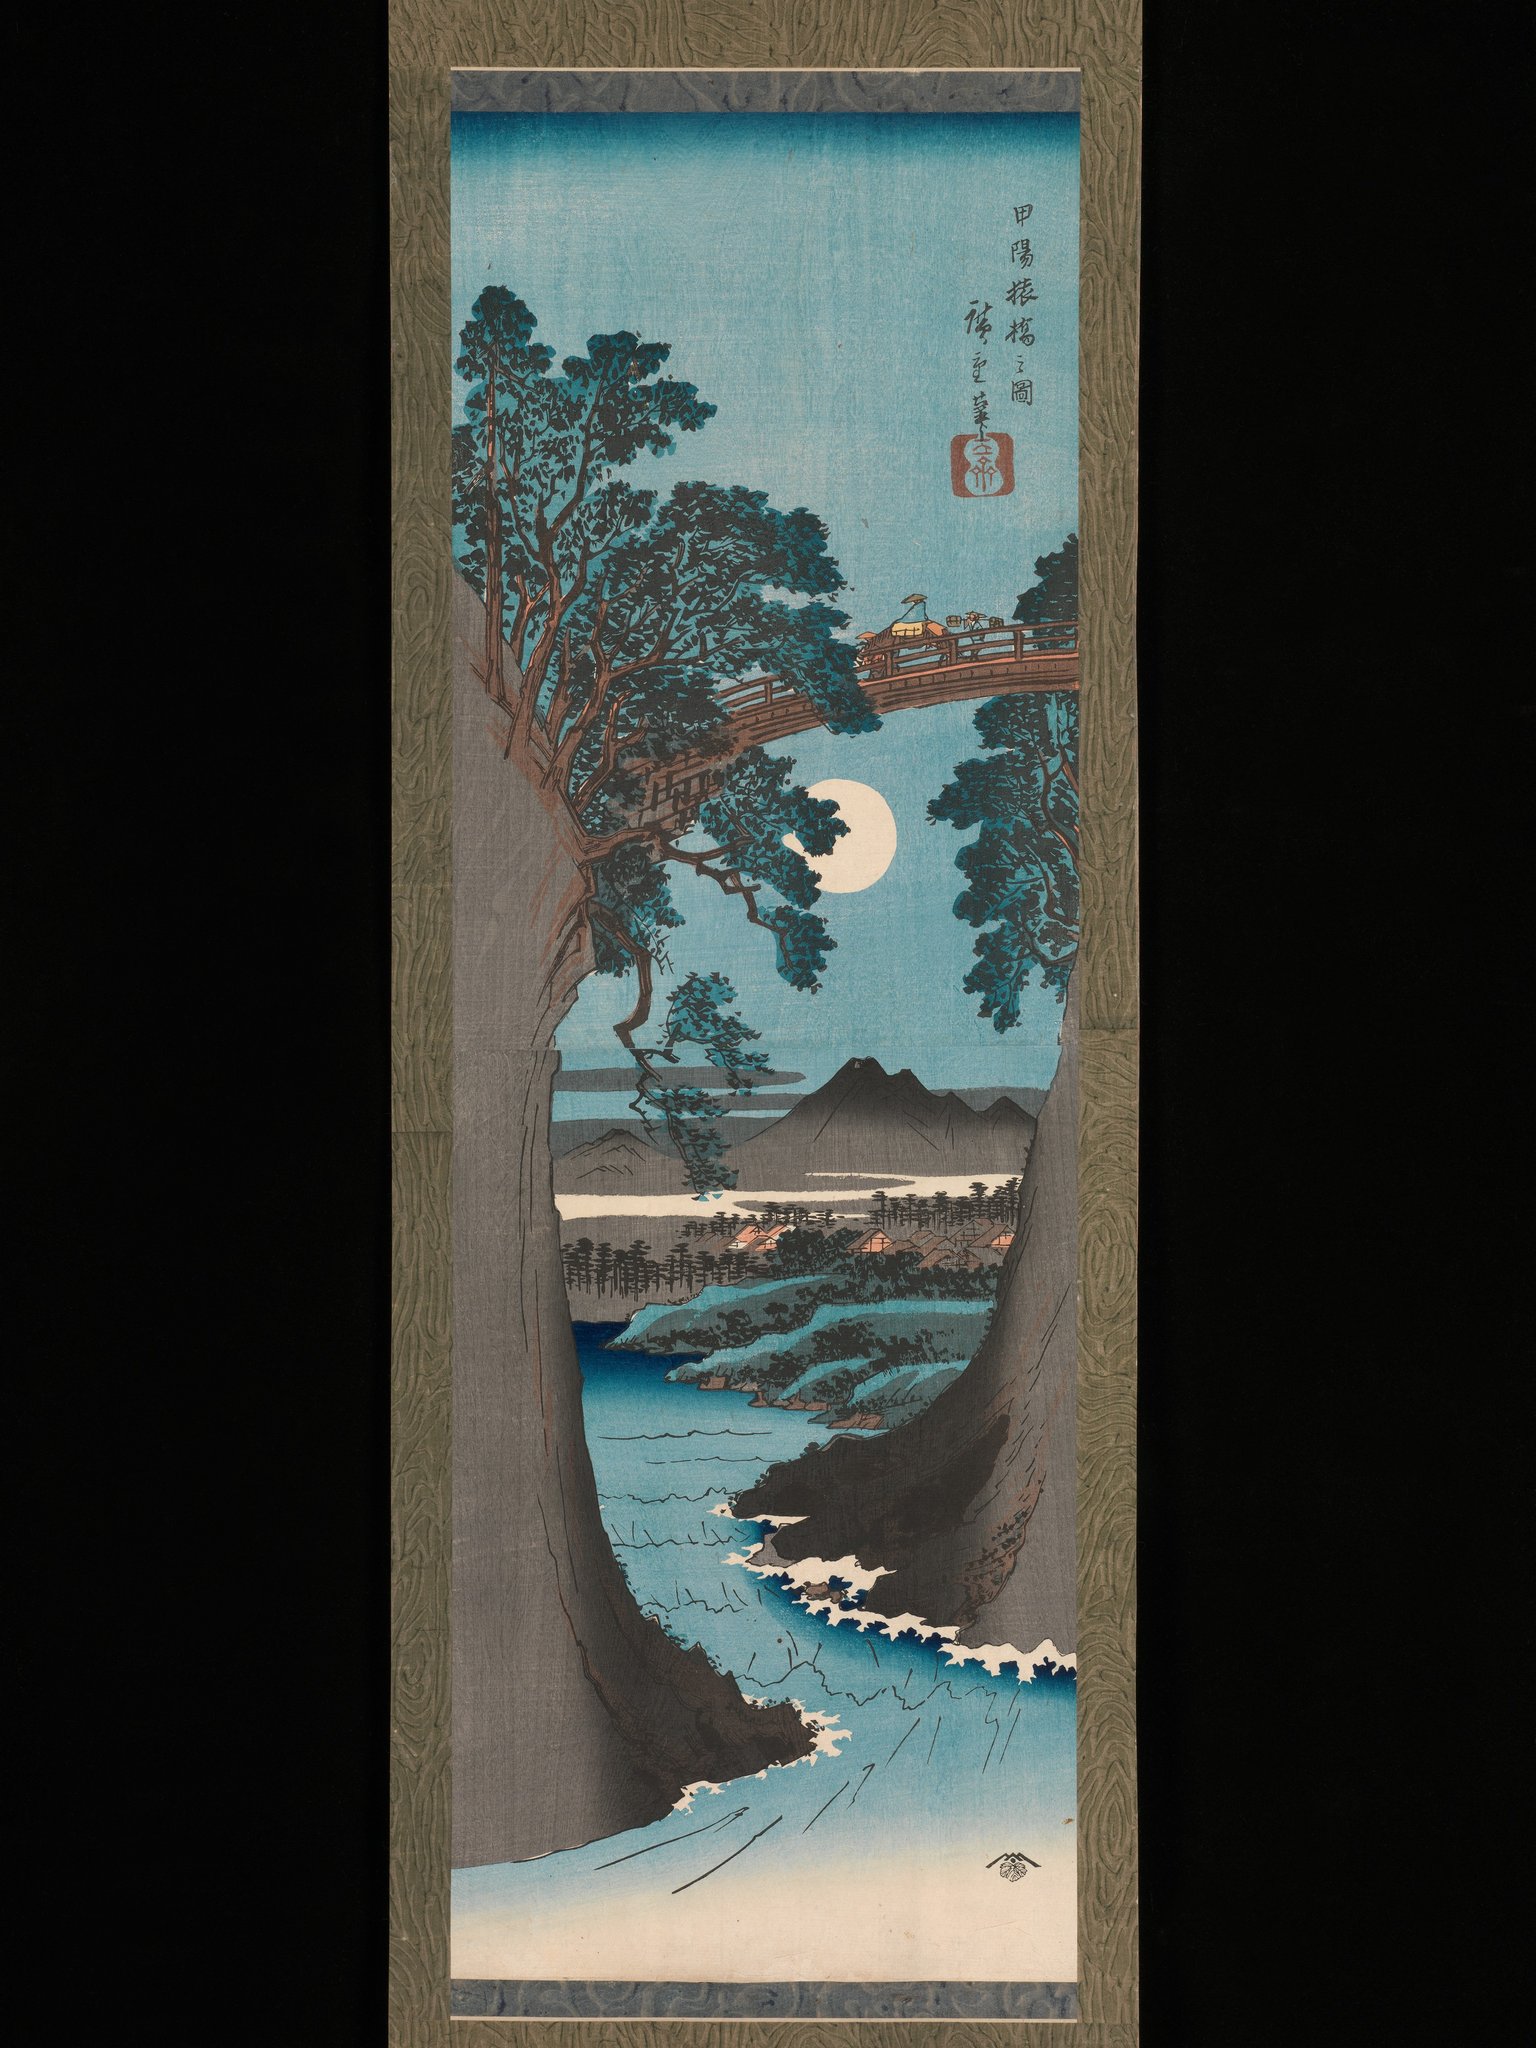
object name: print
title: The Monkey Bridge in Kai Province (Kōyō Saruhashi no zu)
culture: japanese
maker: utagawa hiroshige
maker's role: artist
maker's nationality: japanese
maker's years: 1797-1858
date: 1841-1842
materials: ink, paper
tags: bridges,moon,landscapes,streams